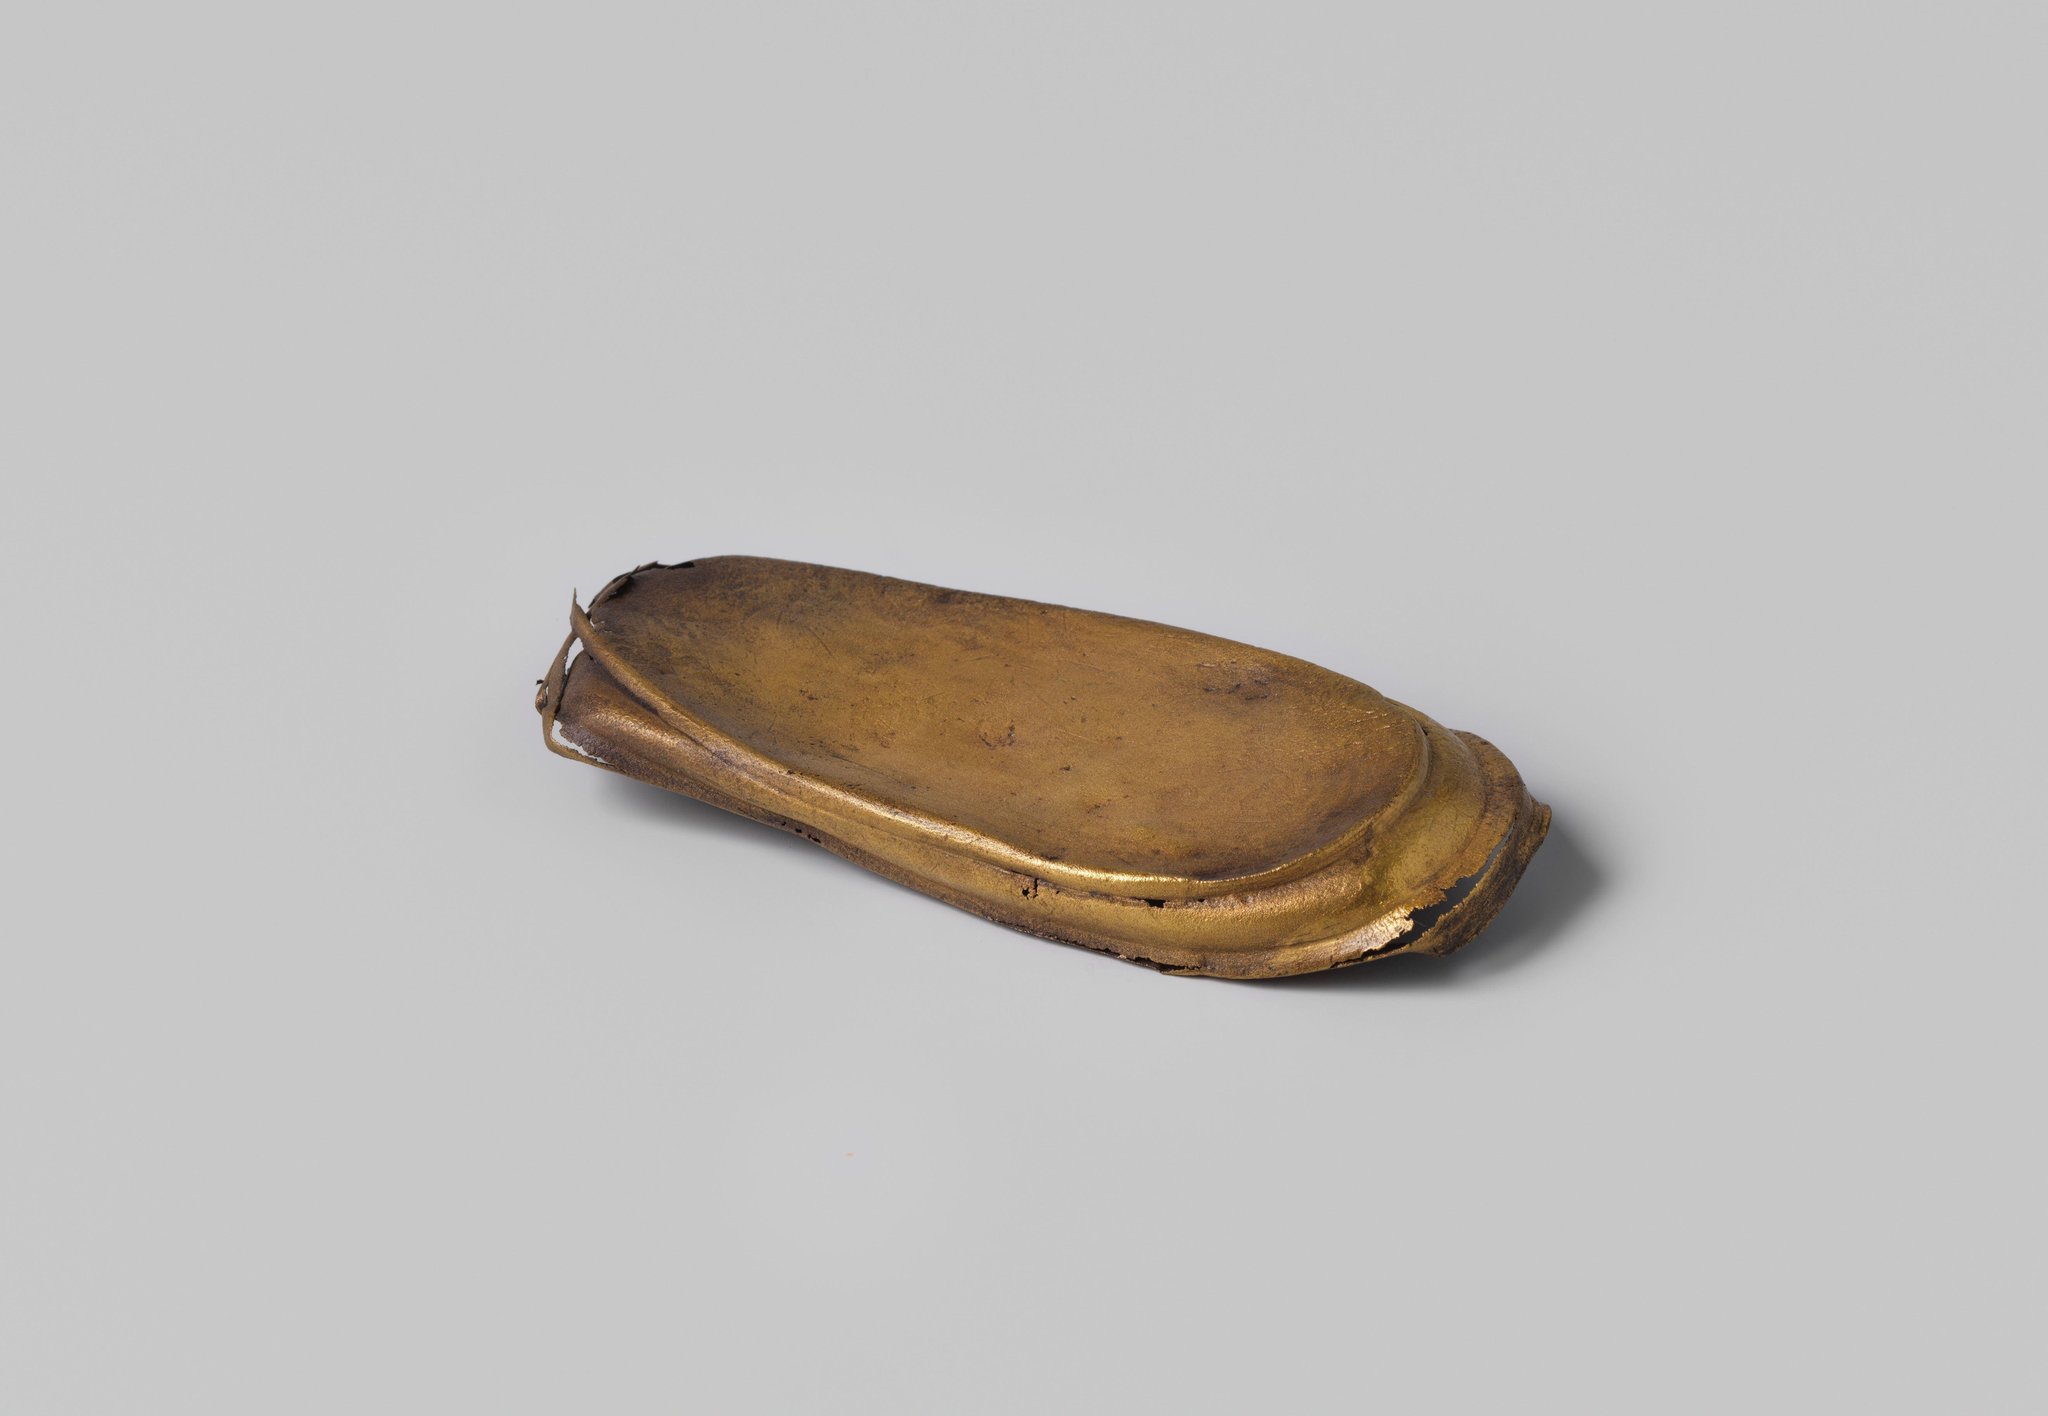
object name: box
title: Tabaksdoos zonder deksel uit het wrak van de Oost-Indiëvaarder Hollandia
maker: Anonymous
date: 1700-1743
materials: copper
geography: netherlands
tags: verenigde oostindische compagnie, hollandia (schip), annet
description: Tobacco box; fragm, lid, squashed, oval (hinge originally five-lugged).